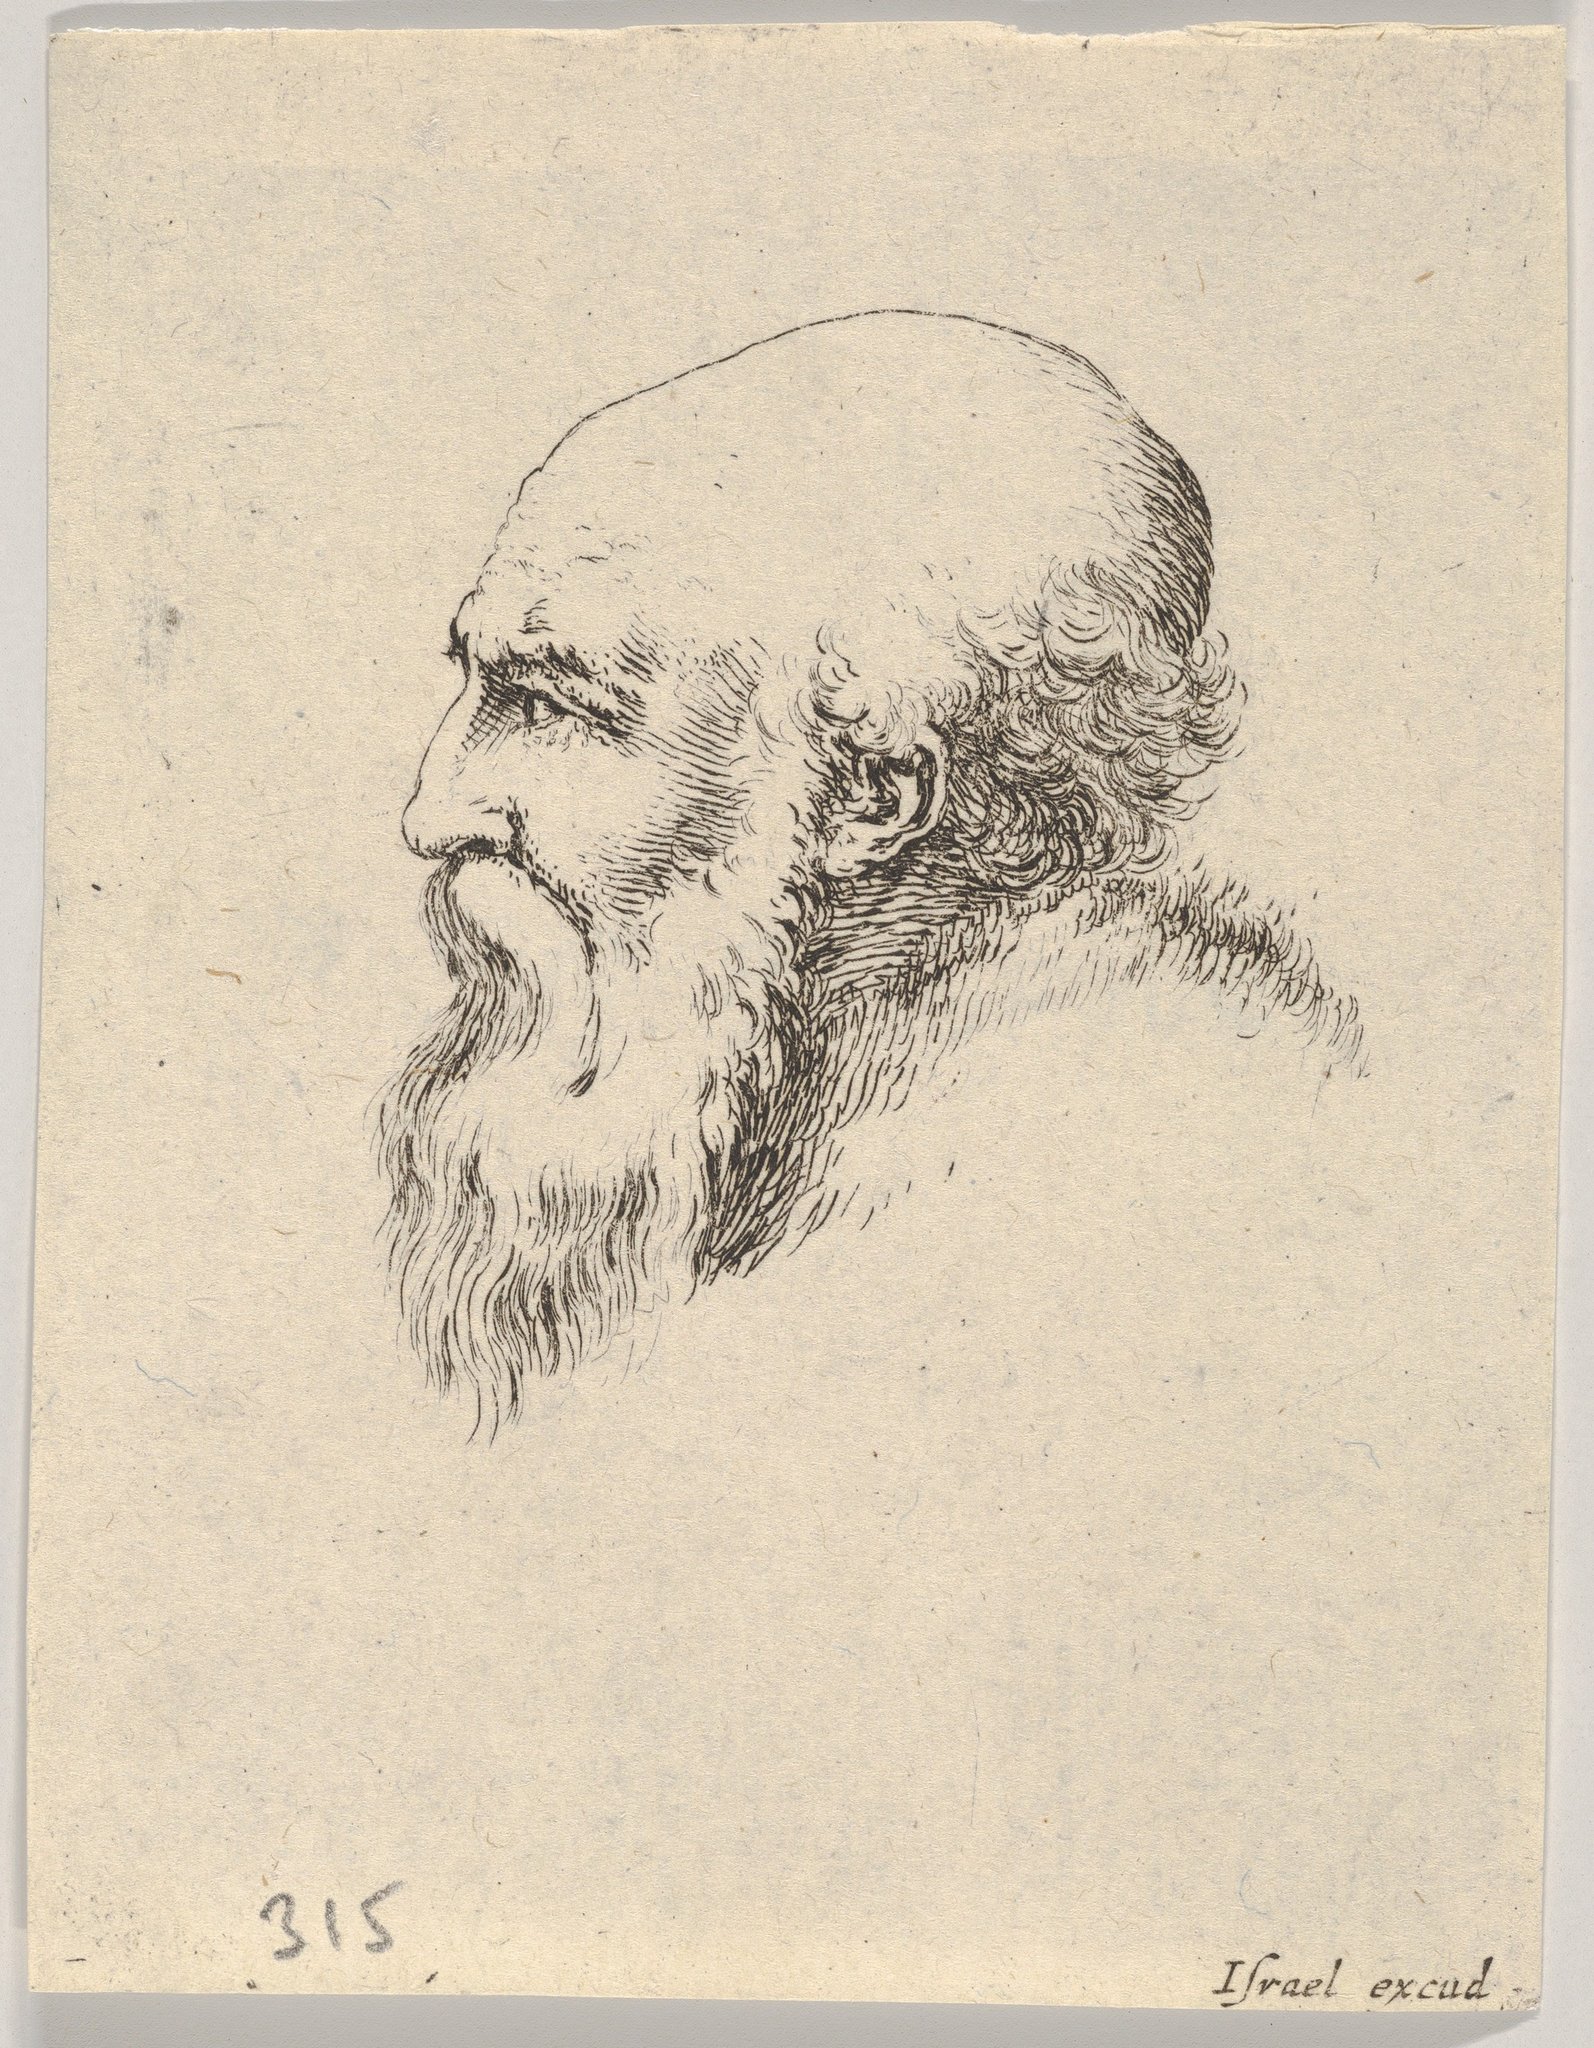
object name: print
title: Plate 8: Head of an old bald man with a long beard, facing left in profile, from "Various heads and figures" (Diverses têtes et figures)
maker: stefano della bella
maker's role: artist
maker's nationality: italian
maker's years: 1610-1664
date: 1650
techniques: etching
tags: men,profiles